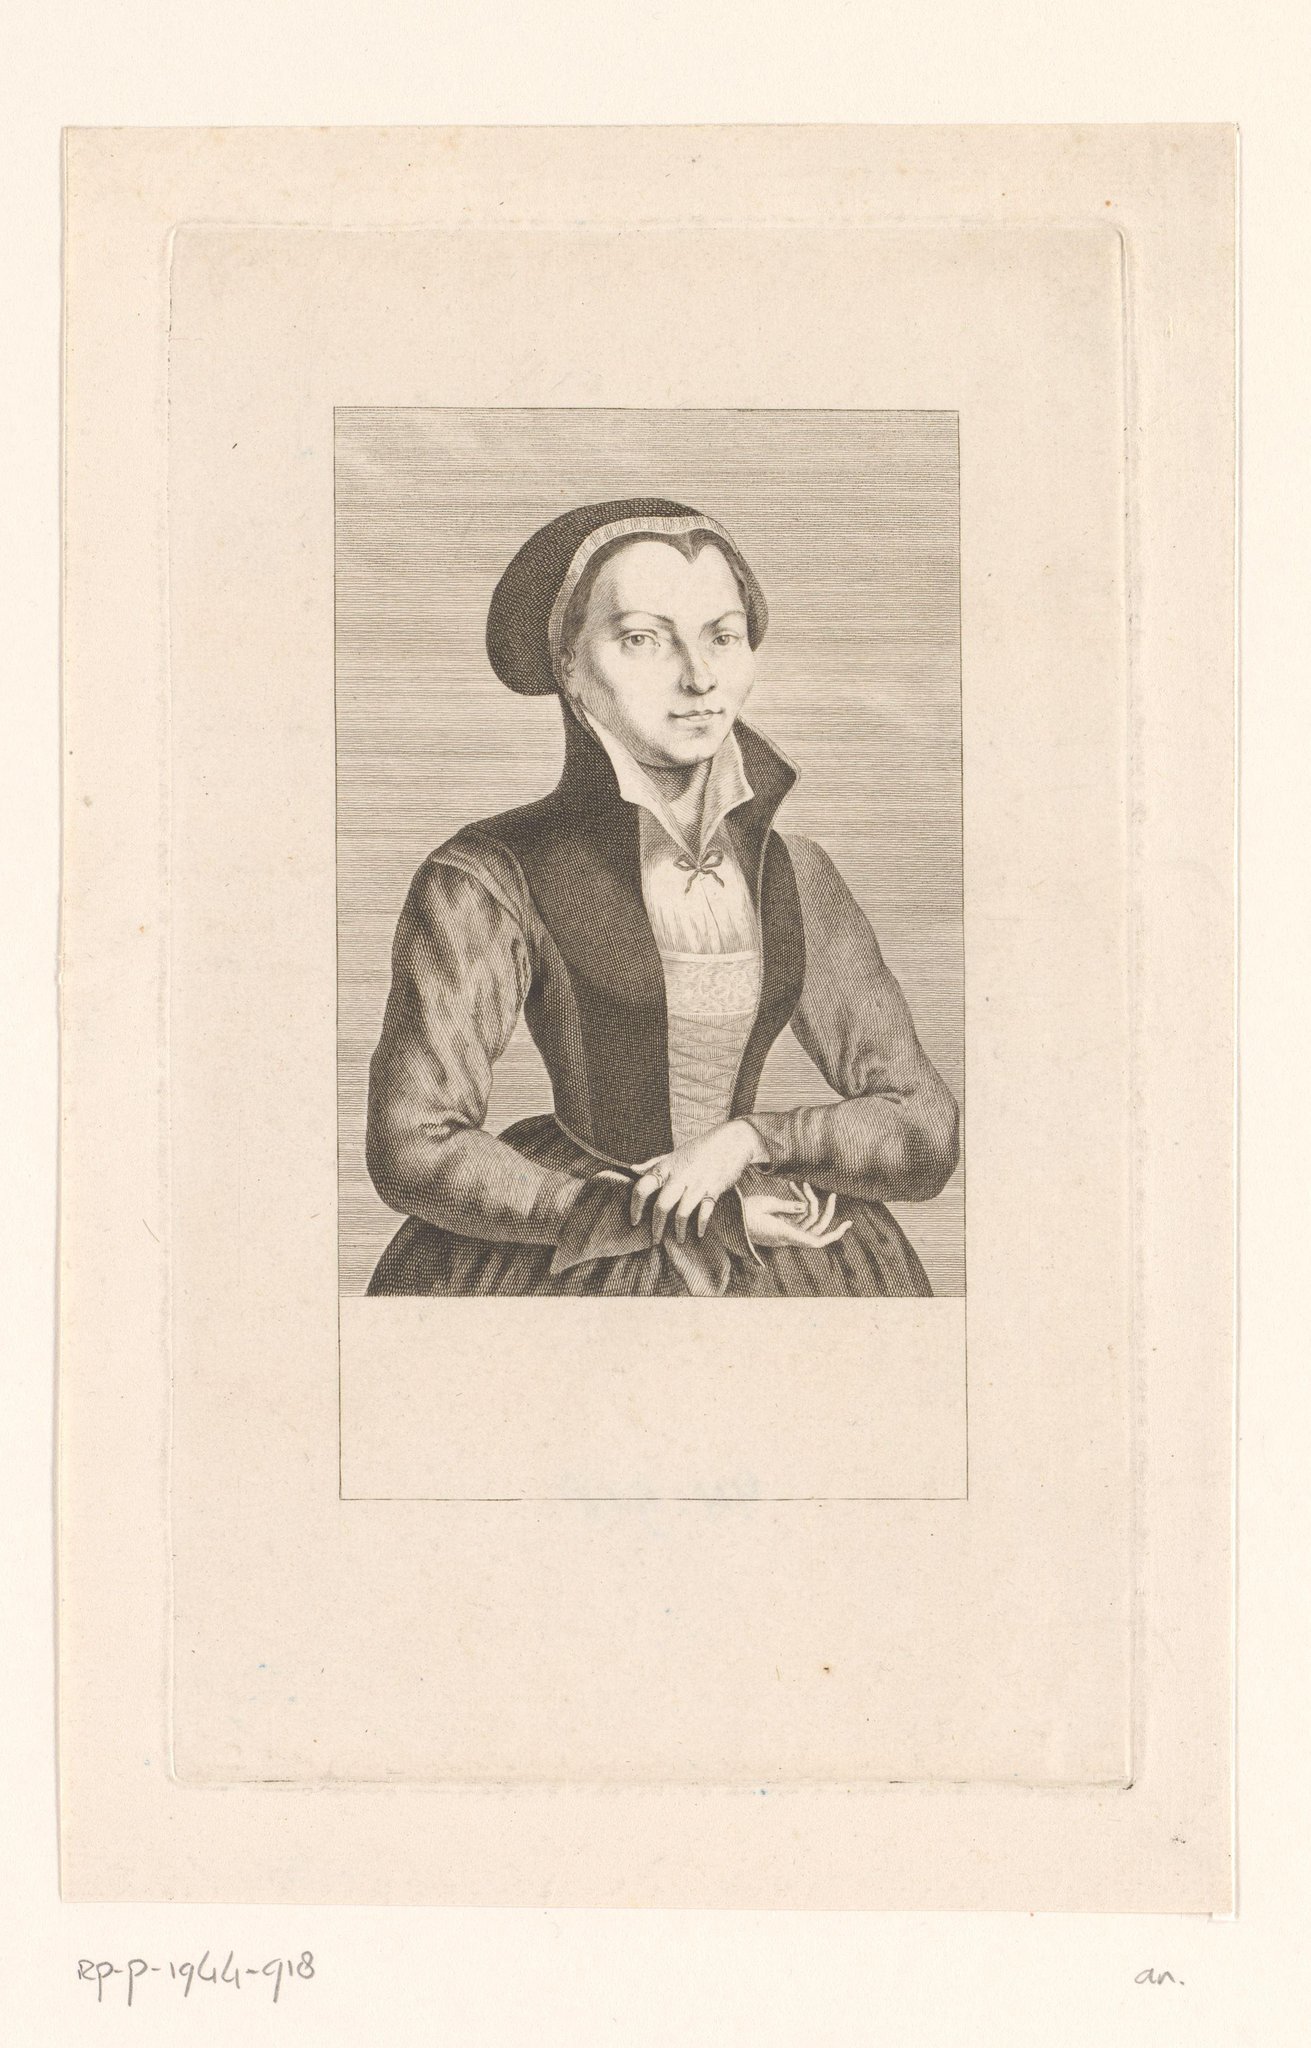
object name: print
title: Portret van Katharina von Bora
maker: Anonymous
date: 1770-1870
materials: paper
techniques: engraving, etching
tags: historical persons - bb - woman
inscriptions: collector's mark: Lugt 2228